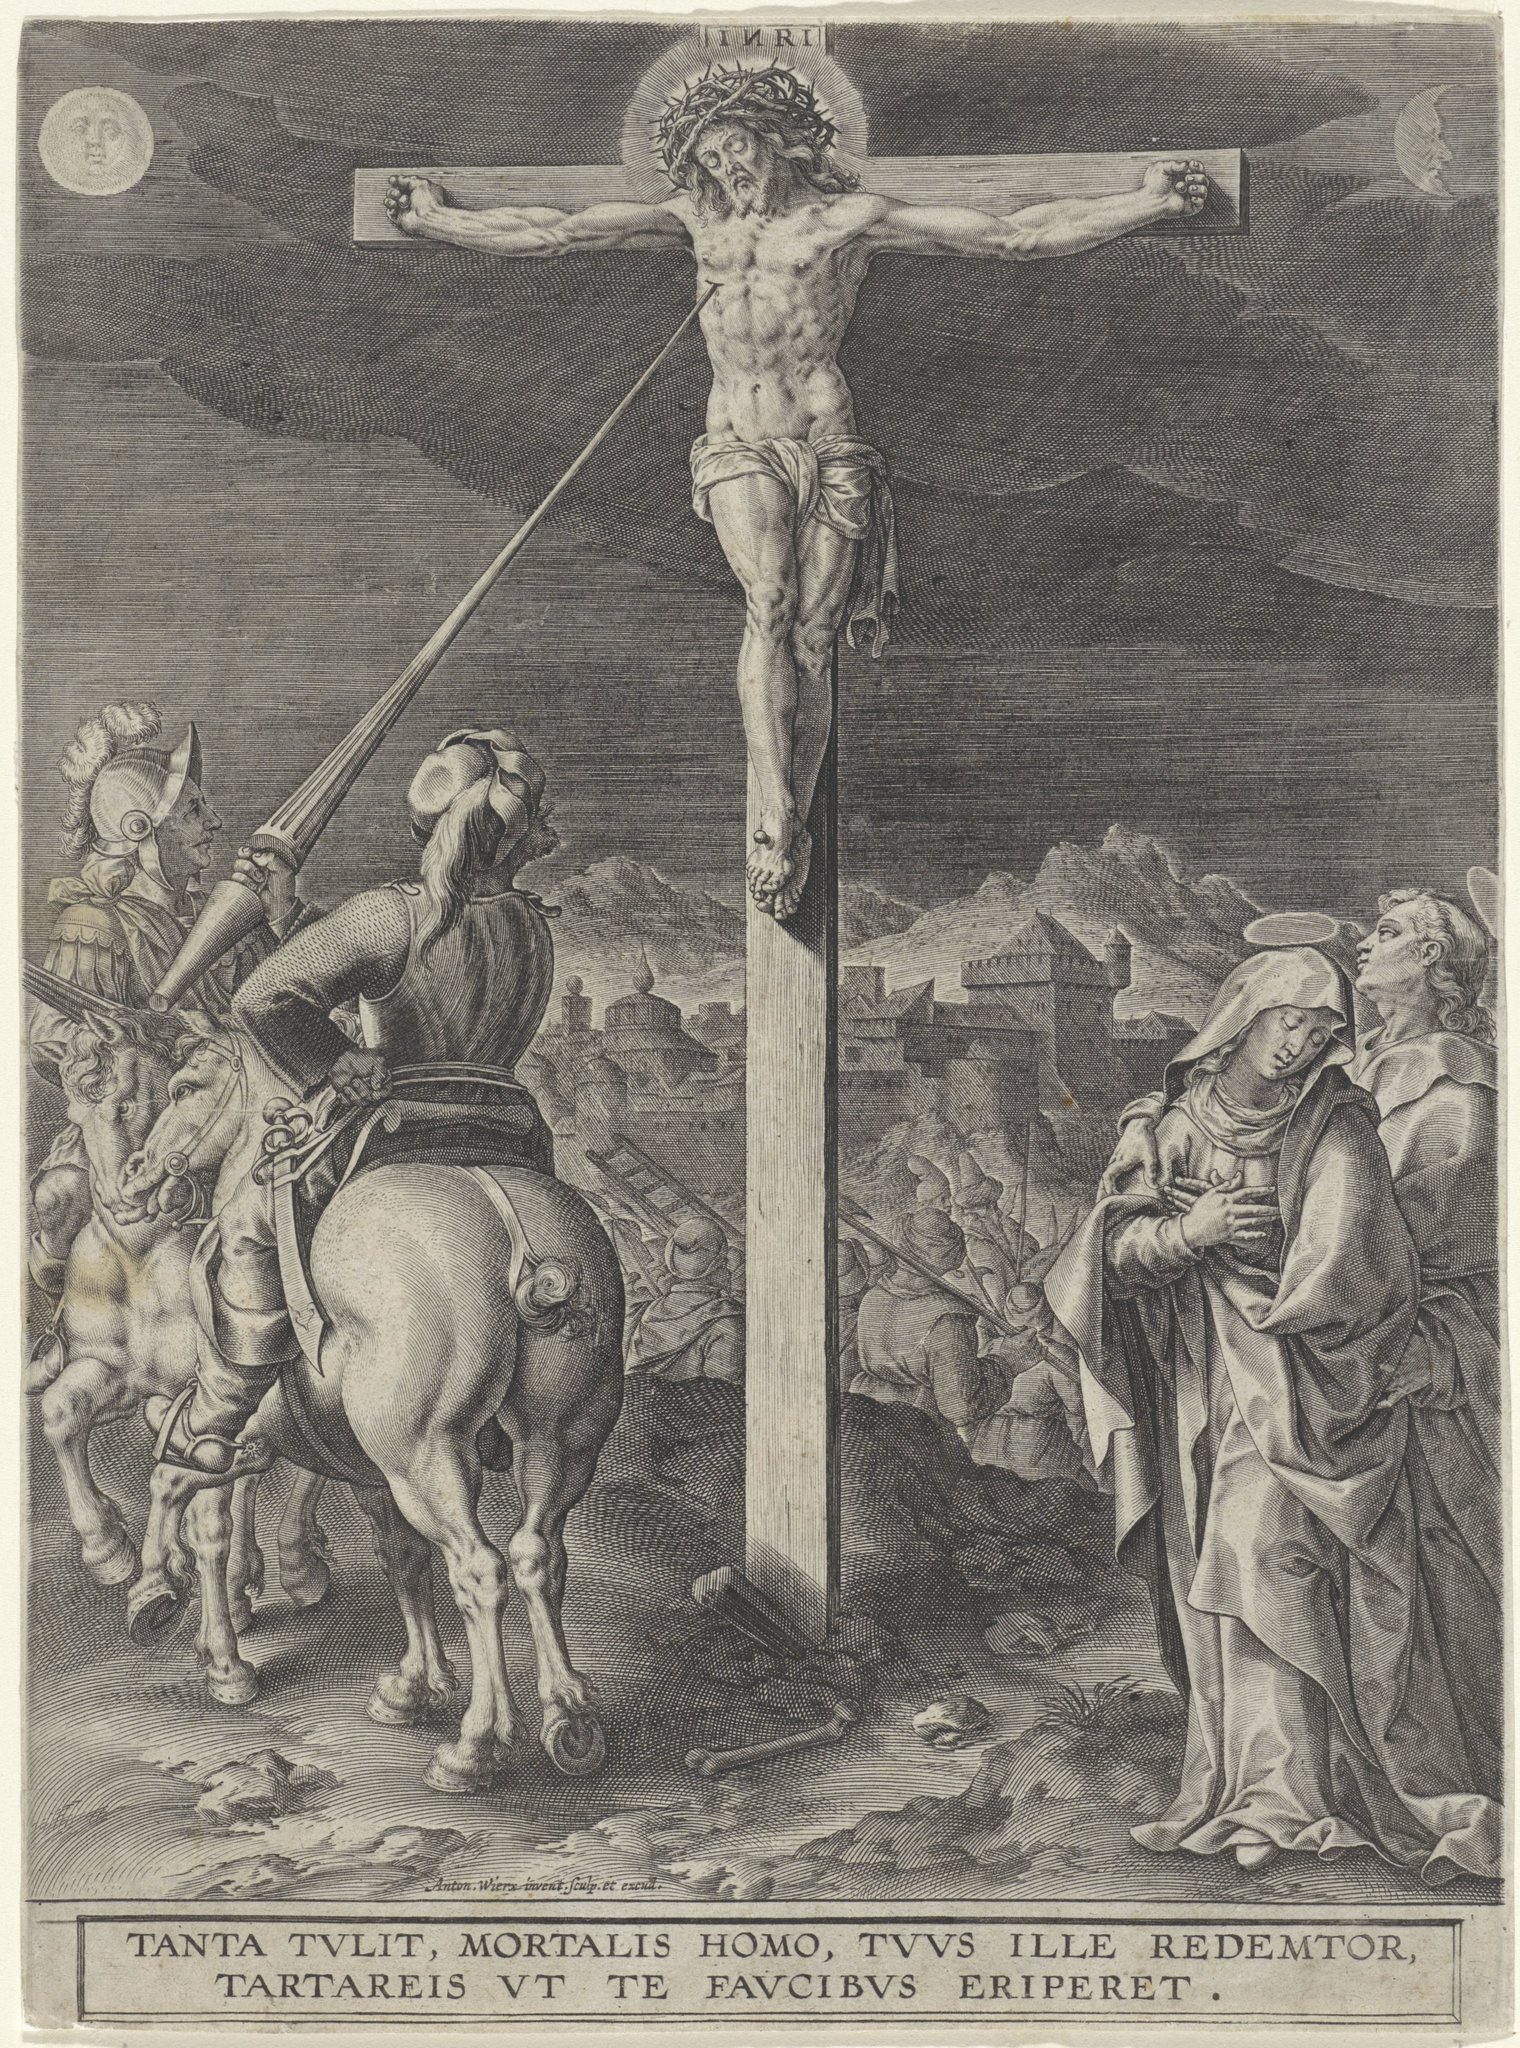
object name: print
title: Kruisiging van Christus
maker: antonie wierix (ii)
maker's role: draughtsman, print maker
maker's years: 1555-1604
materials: paper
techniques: engraving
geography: antwerp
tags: crucified christ, with particular persons under the cross, longinus pierces christ's side with a lance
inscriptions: collector's mark: Lugt 2228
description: Kruisdood van Christus op Golgota. Een soldaat steekt zijn lans in de zijde van Christus. Maria en Johannes treuren bij het kruis. Linksboven is nog de zon te zien in de duisternis. Na de kruisiging van Christus was er een zonsverduistering, een teken dat de hemel rouwde om zijn dood. In de marge een tweeregelig onderschrift in het Latijn.